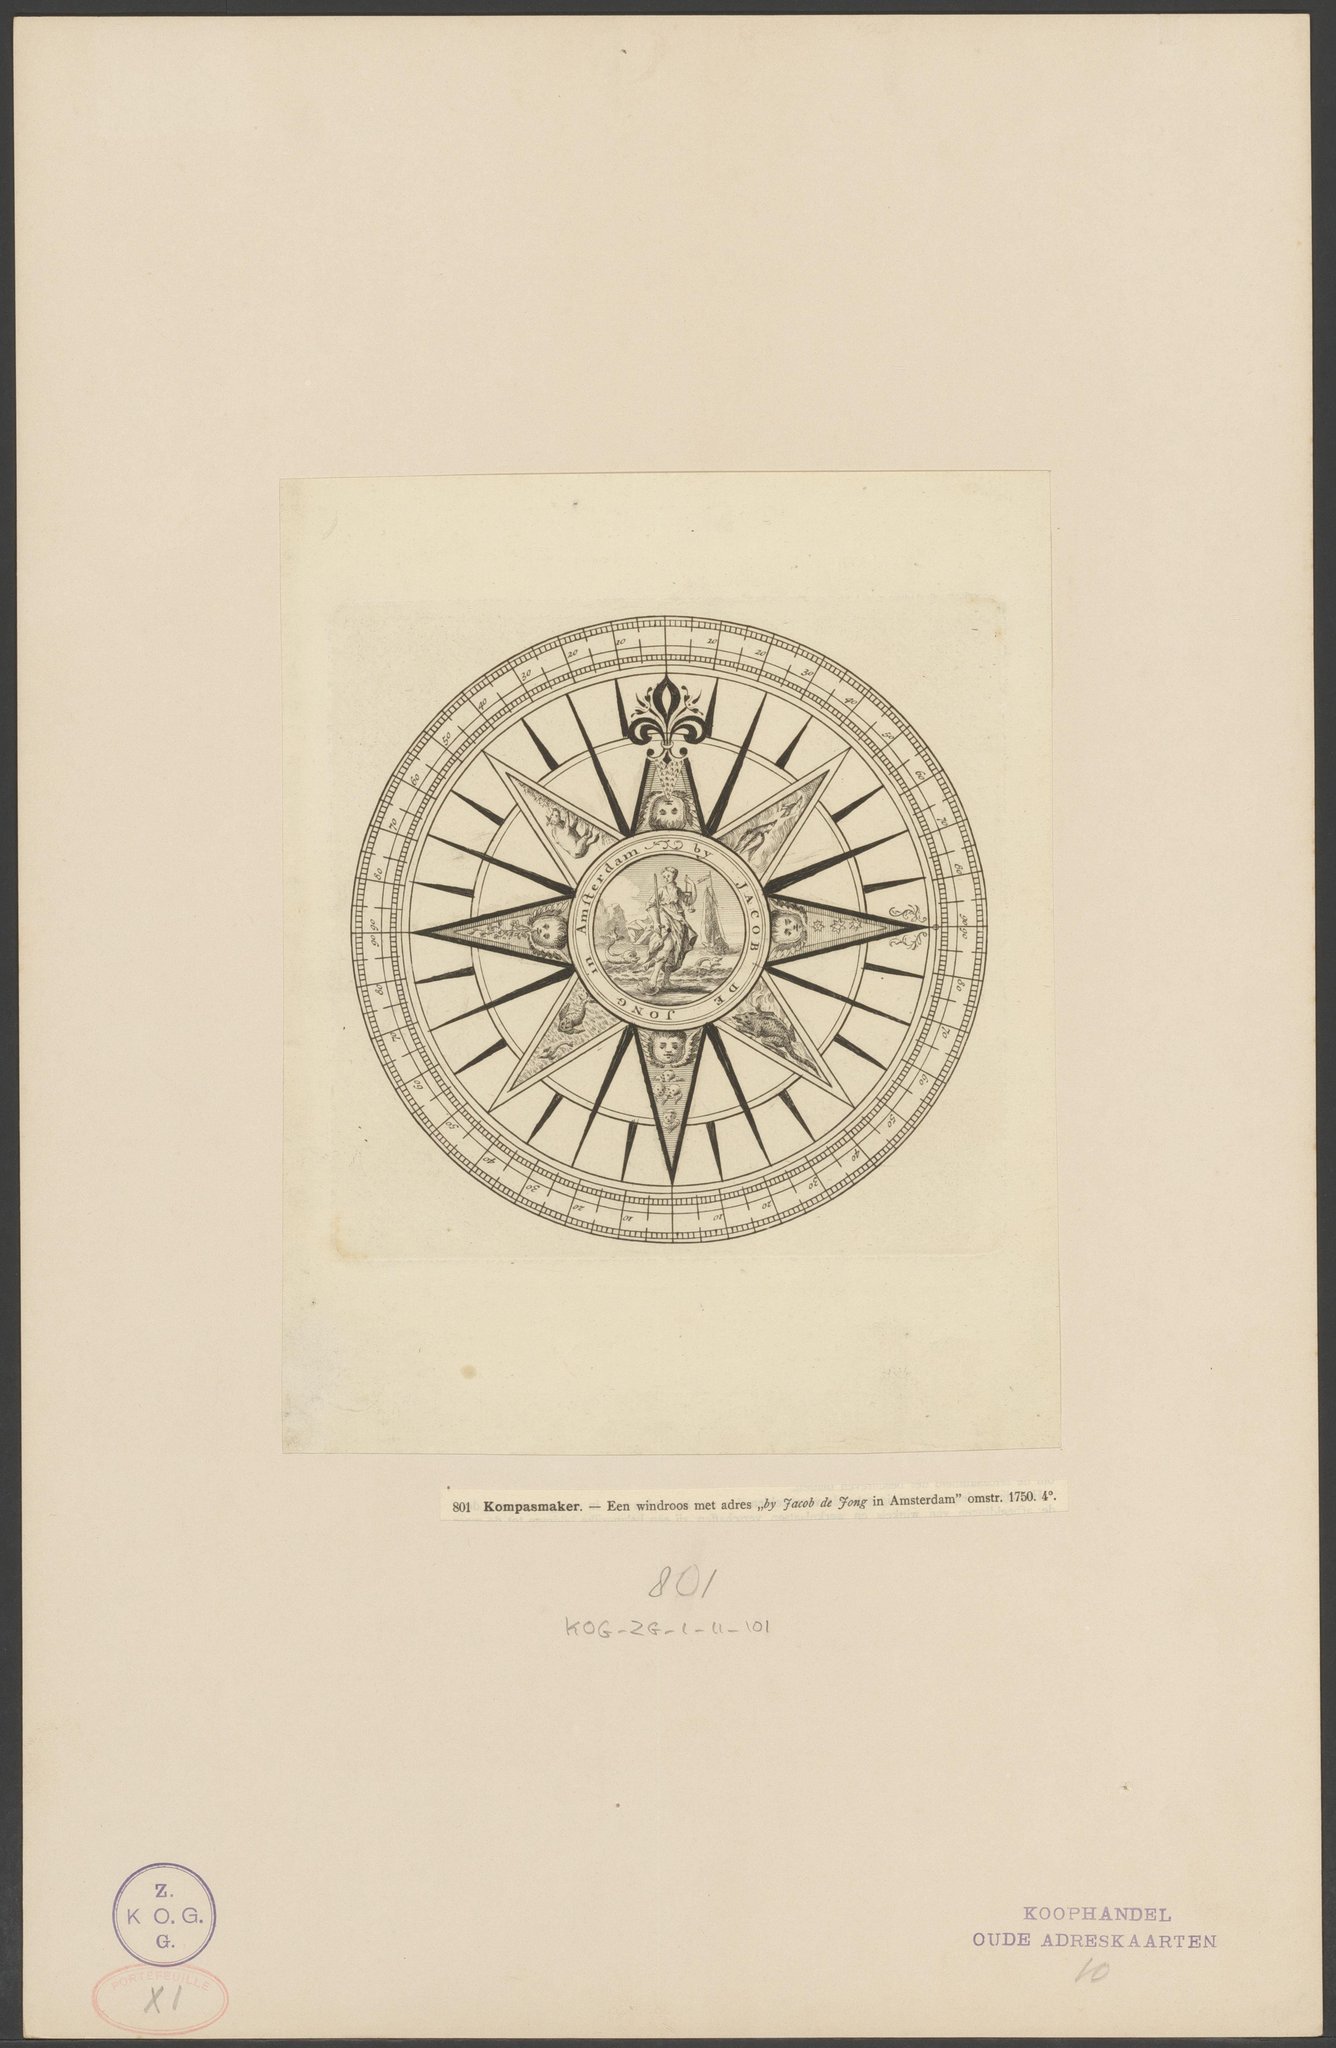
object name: business card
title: Adreskaart van de kompasmaker Jacob de Jong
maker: Anonymous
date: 1700-1799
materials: paper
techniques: engraving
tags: amsterdam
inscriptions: stamp, stamp, collector's mark: Lugt 1641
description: Adreskaart van de kompasmaker Jacob de Jong in Amsterdam. Windroos met in het midden Vrouwe Justitia in de zee. Om haar heen de vier windrichtingen. Onderwerpsrubrieken binnen de Atlas Zeden en Gewoonten: Handel, nijverheid en verkeer, Koophandel, Veilingen, Makelaardij en Verzekeringswezen, Oude adreskaarten van winkels en fabrieken, reclame.